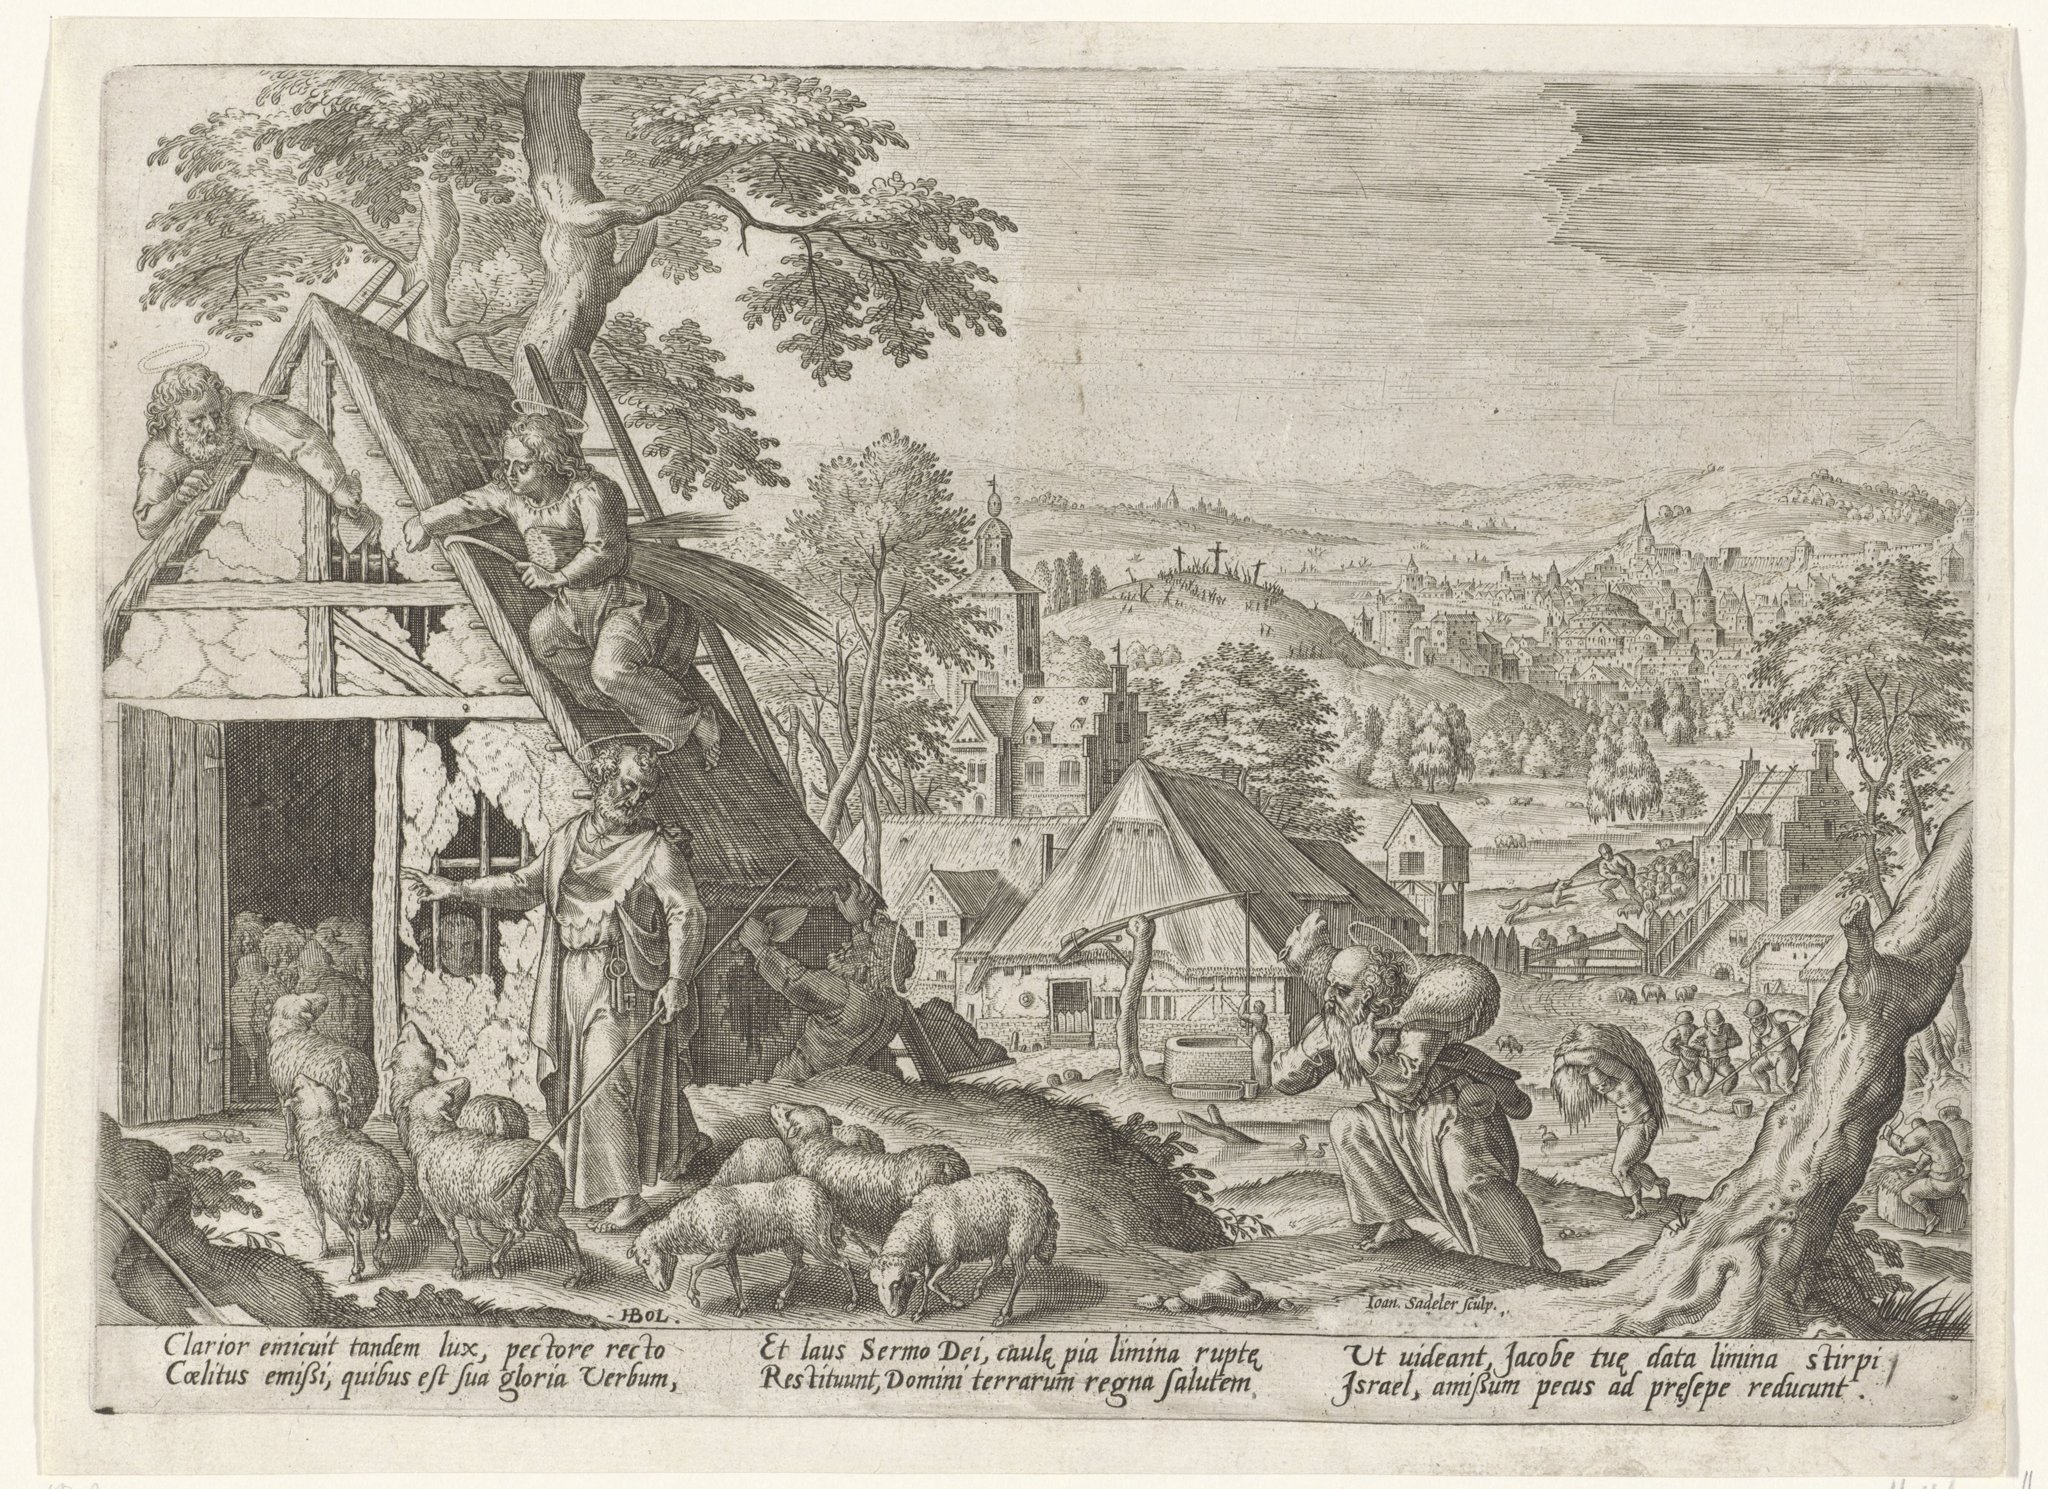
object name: print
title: Gelijkenis van de goede herder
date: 1560-1586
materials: paper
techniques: engraving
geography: antwerp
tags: herding, herdsman, herdswoman, shepherd, shepherdess, cowherd, etc., the good shepherd (christ) defending his sheep against wolves; 'i am the good shepherd' (john 10:1-16), sheep, other groups of apostles, the apostle peter, first bishop of rome; possible attributes: book, cock, (upturned) cross, (triple) crozier, fish, key, scroll, ship, tiara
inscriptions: collector's mark: Lugt 240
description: De apostel Petrus als goede herder. Hij leidt zijn kudde schapen (de gemeenschap van christenen) in een stal (de kerk) die door de andere apostelen in gereedheid wordt gebracht. Op de achtergrond een dorp. Aan de horizon Christus aan het kruis. Eerste prent van een driedelige serie.